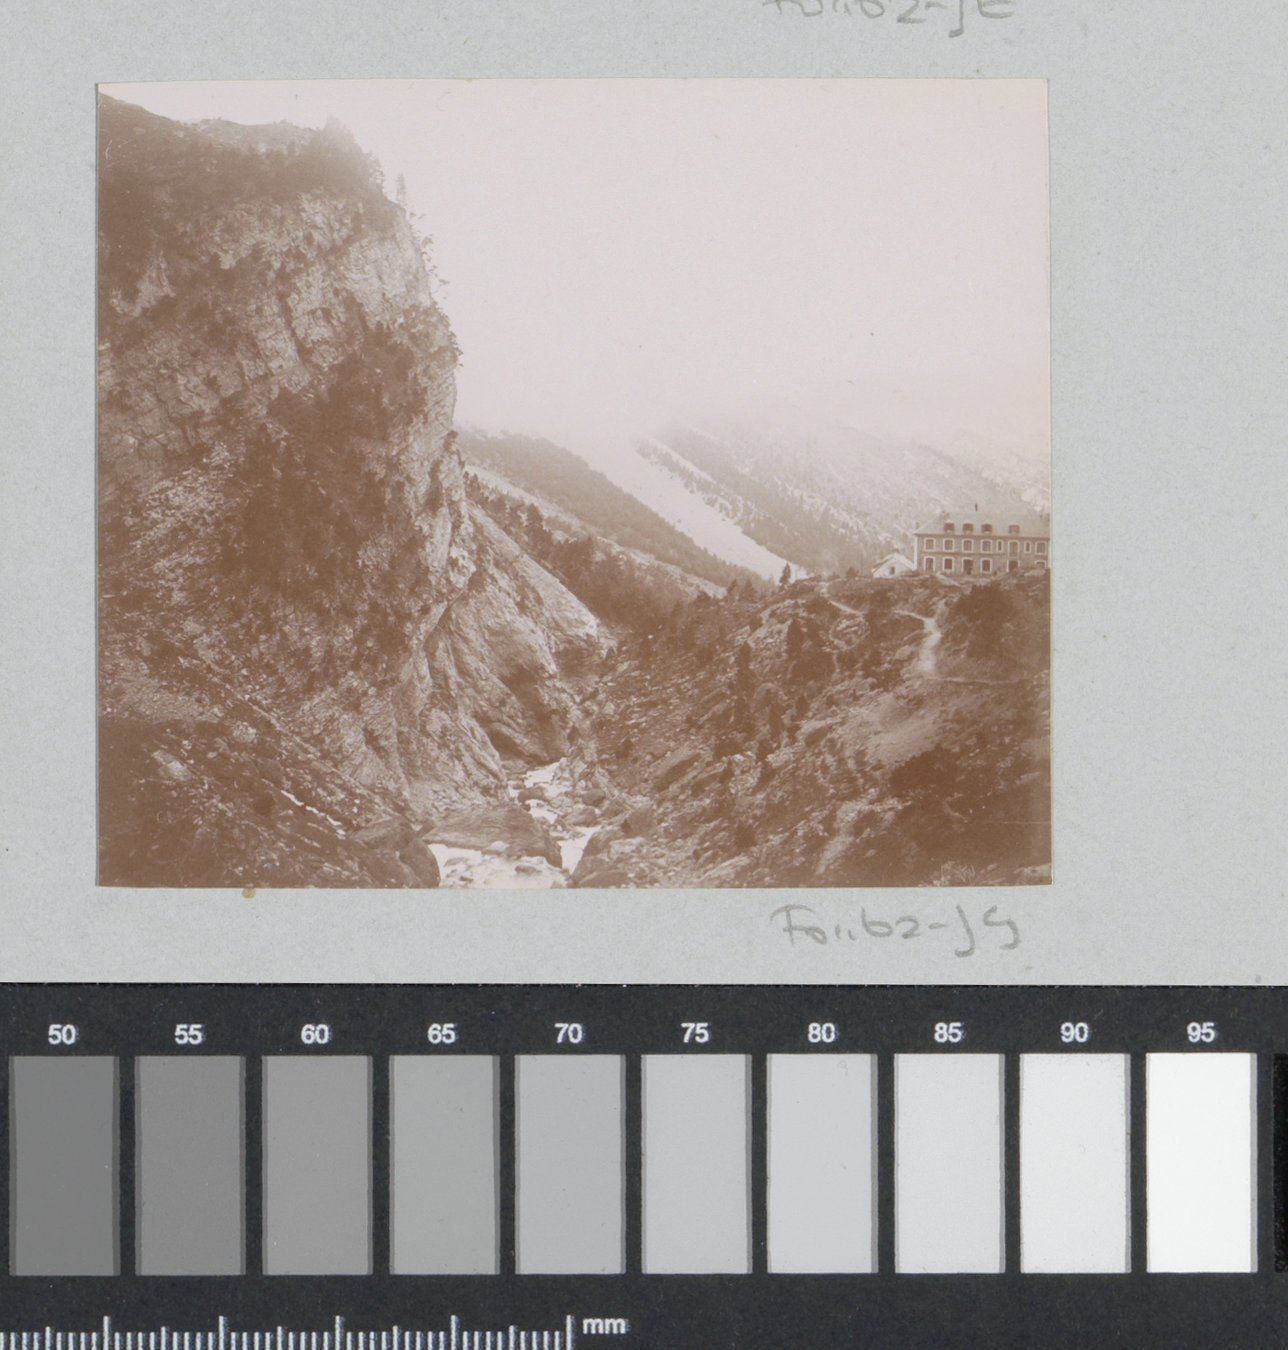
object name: photograph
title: Berglandschap met een huis op een top, vermoedelijk in de Pyreneeën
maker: Anonymous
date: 1905-1910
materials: paper, photographic support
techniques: gelatin silver print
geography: pyrenees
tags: mountains (+ landscape with figures, staffage)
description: Onderdeel van Fotoalbum van een Franse amateurfotograaf met bezienswaardigheden in Frankrijk, Zwitserland en Italië.